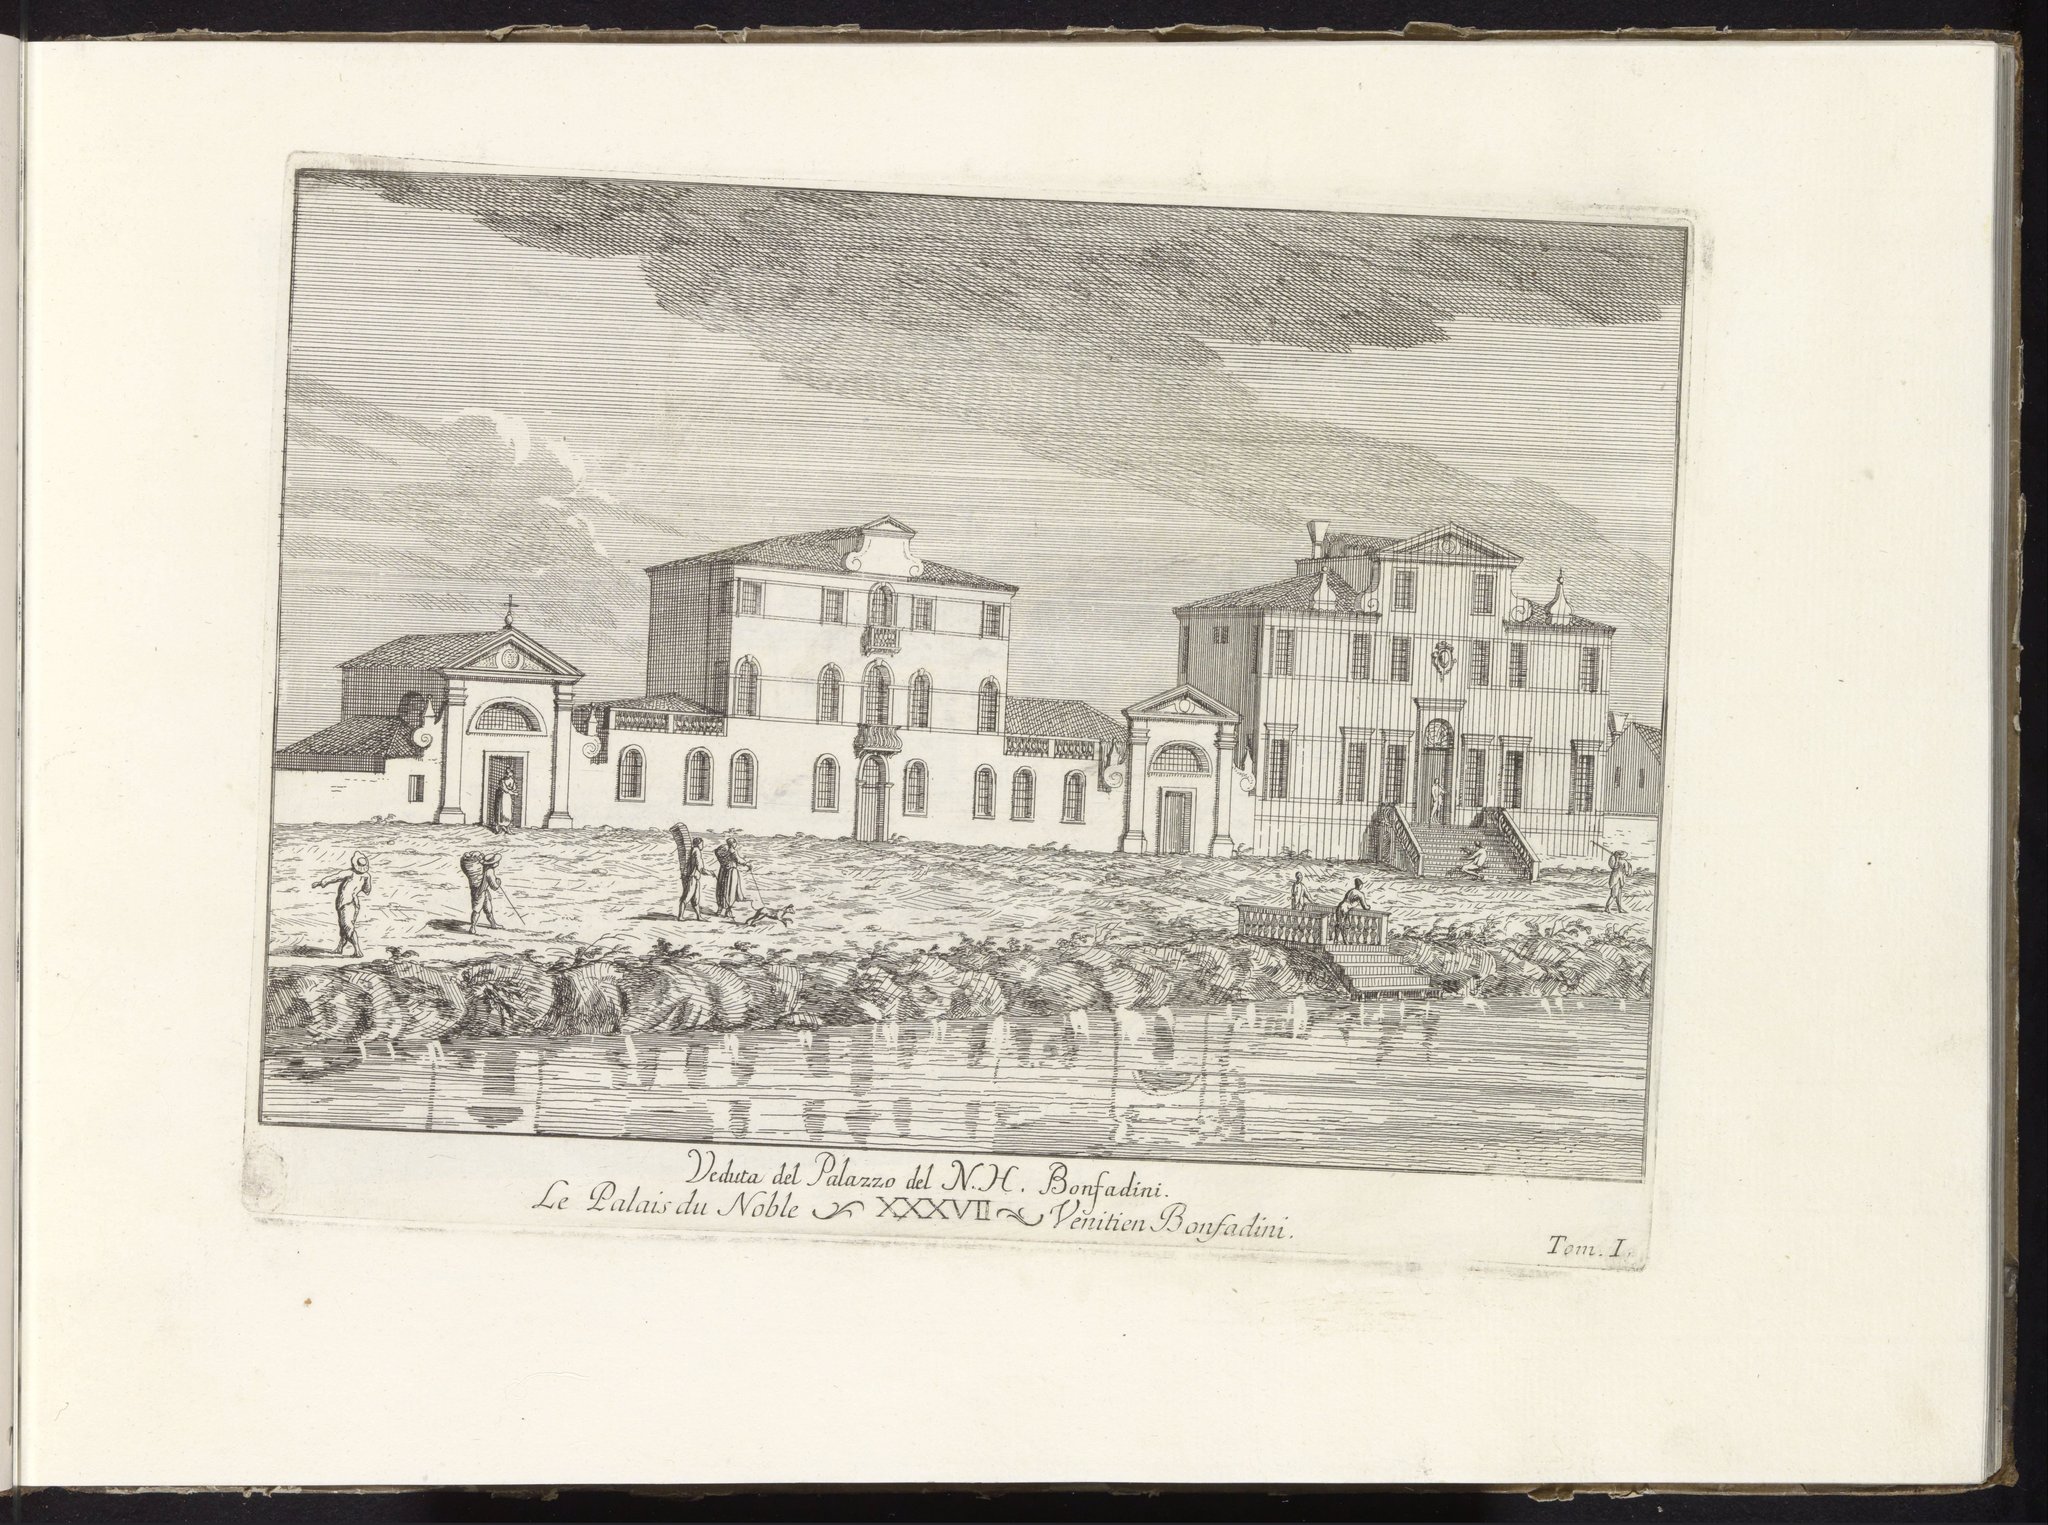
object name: print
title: Palazzo del N. H. Bonfadini aan de Brenta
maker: giovanni francesco costa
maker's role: draughtsman, painter, print maker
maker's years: -1773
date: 1750-1760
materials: paper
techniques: etching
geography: venice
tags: river, hôtel, i.e. small palace in city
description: Gezicht op Palazzo del N. H. Bonfadini aan de rivier de Brenta. Genummerd midden onder: XXXVII en rechtsonder: Tom: I. Deze prent maakt deel uit van een album.